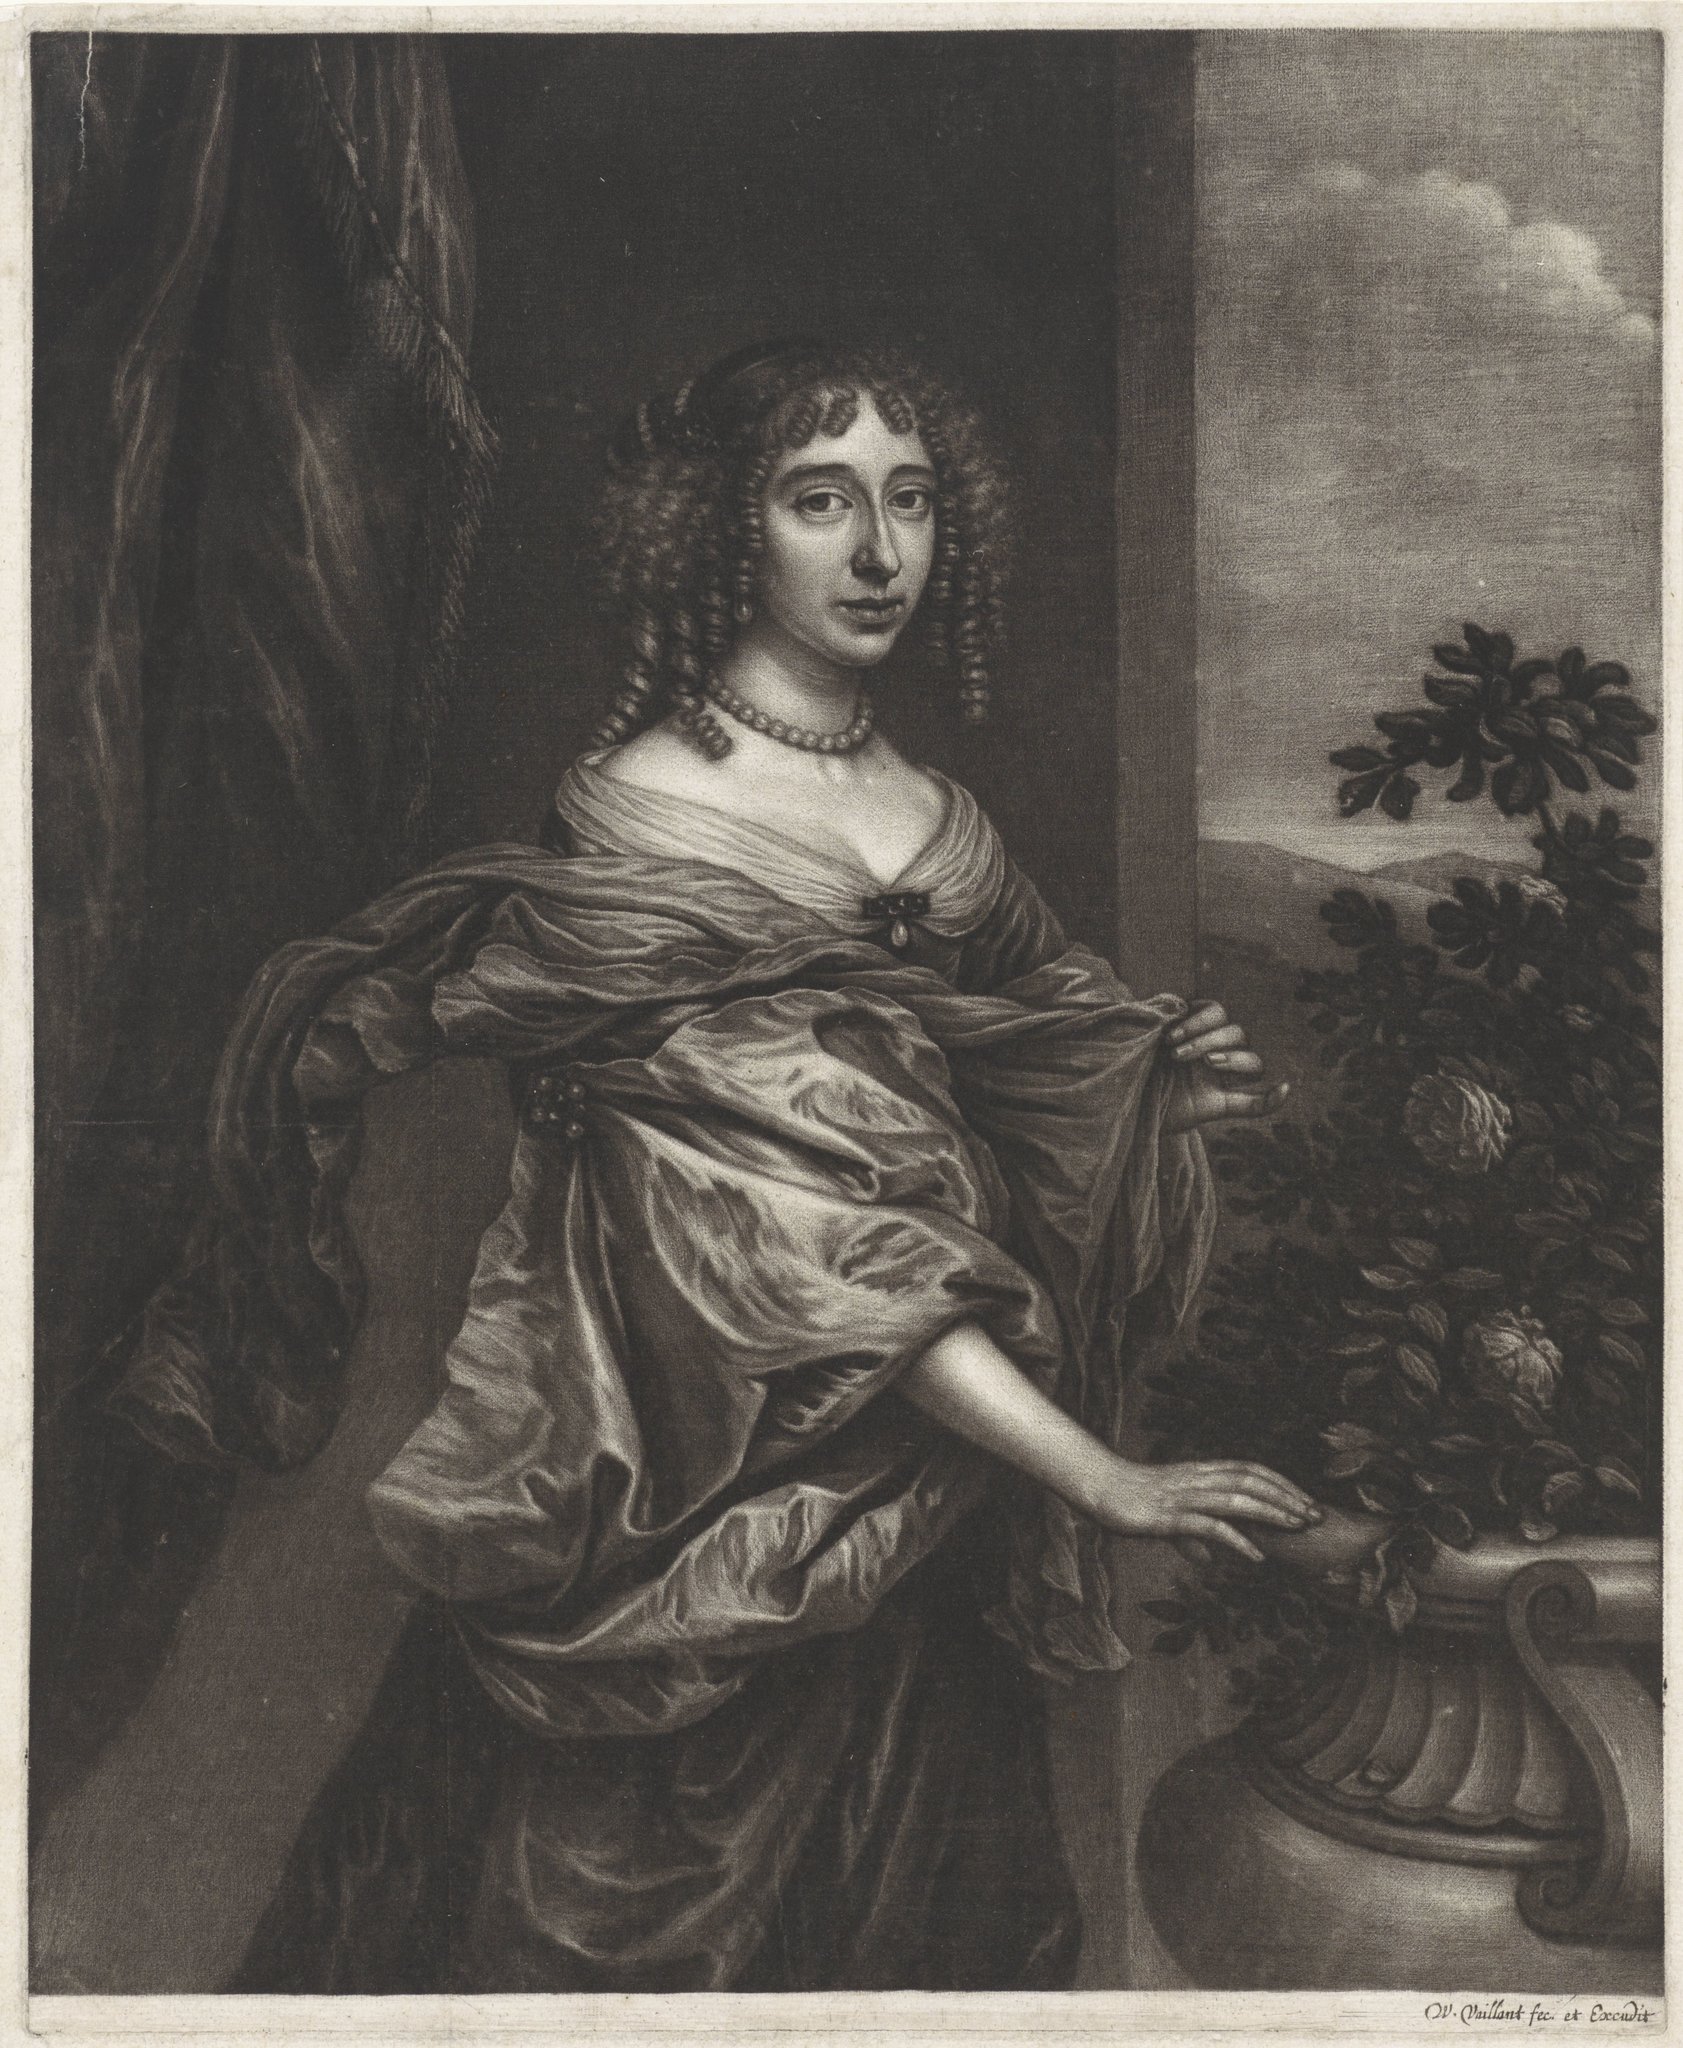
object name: print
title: Portret van een vrouw bij een rozenstruik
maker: wallerant vaillant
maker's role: draughtsman, painter, print maker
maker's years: 1623-1677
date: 1658-1677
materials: paper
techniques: mezzotint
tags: shrubs: rose-bush, necklace (+ women's clothes)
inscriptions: collector's mark: Lugt 963, collector's mark: Lugt 2165